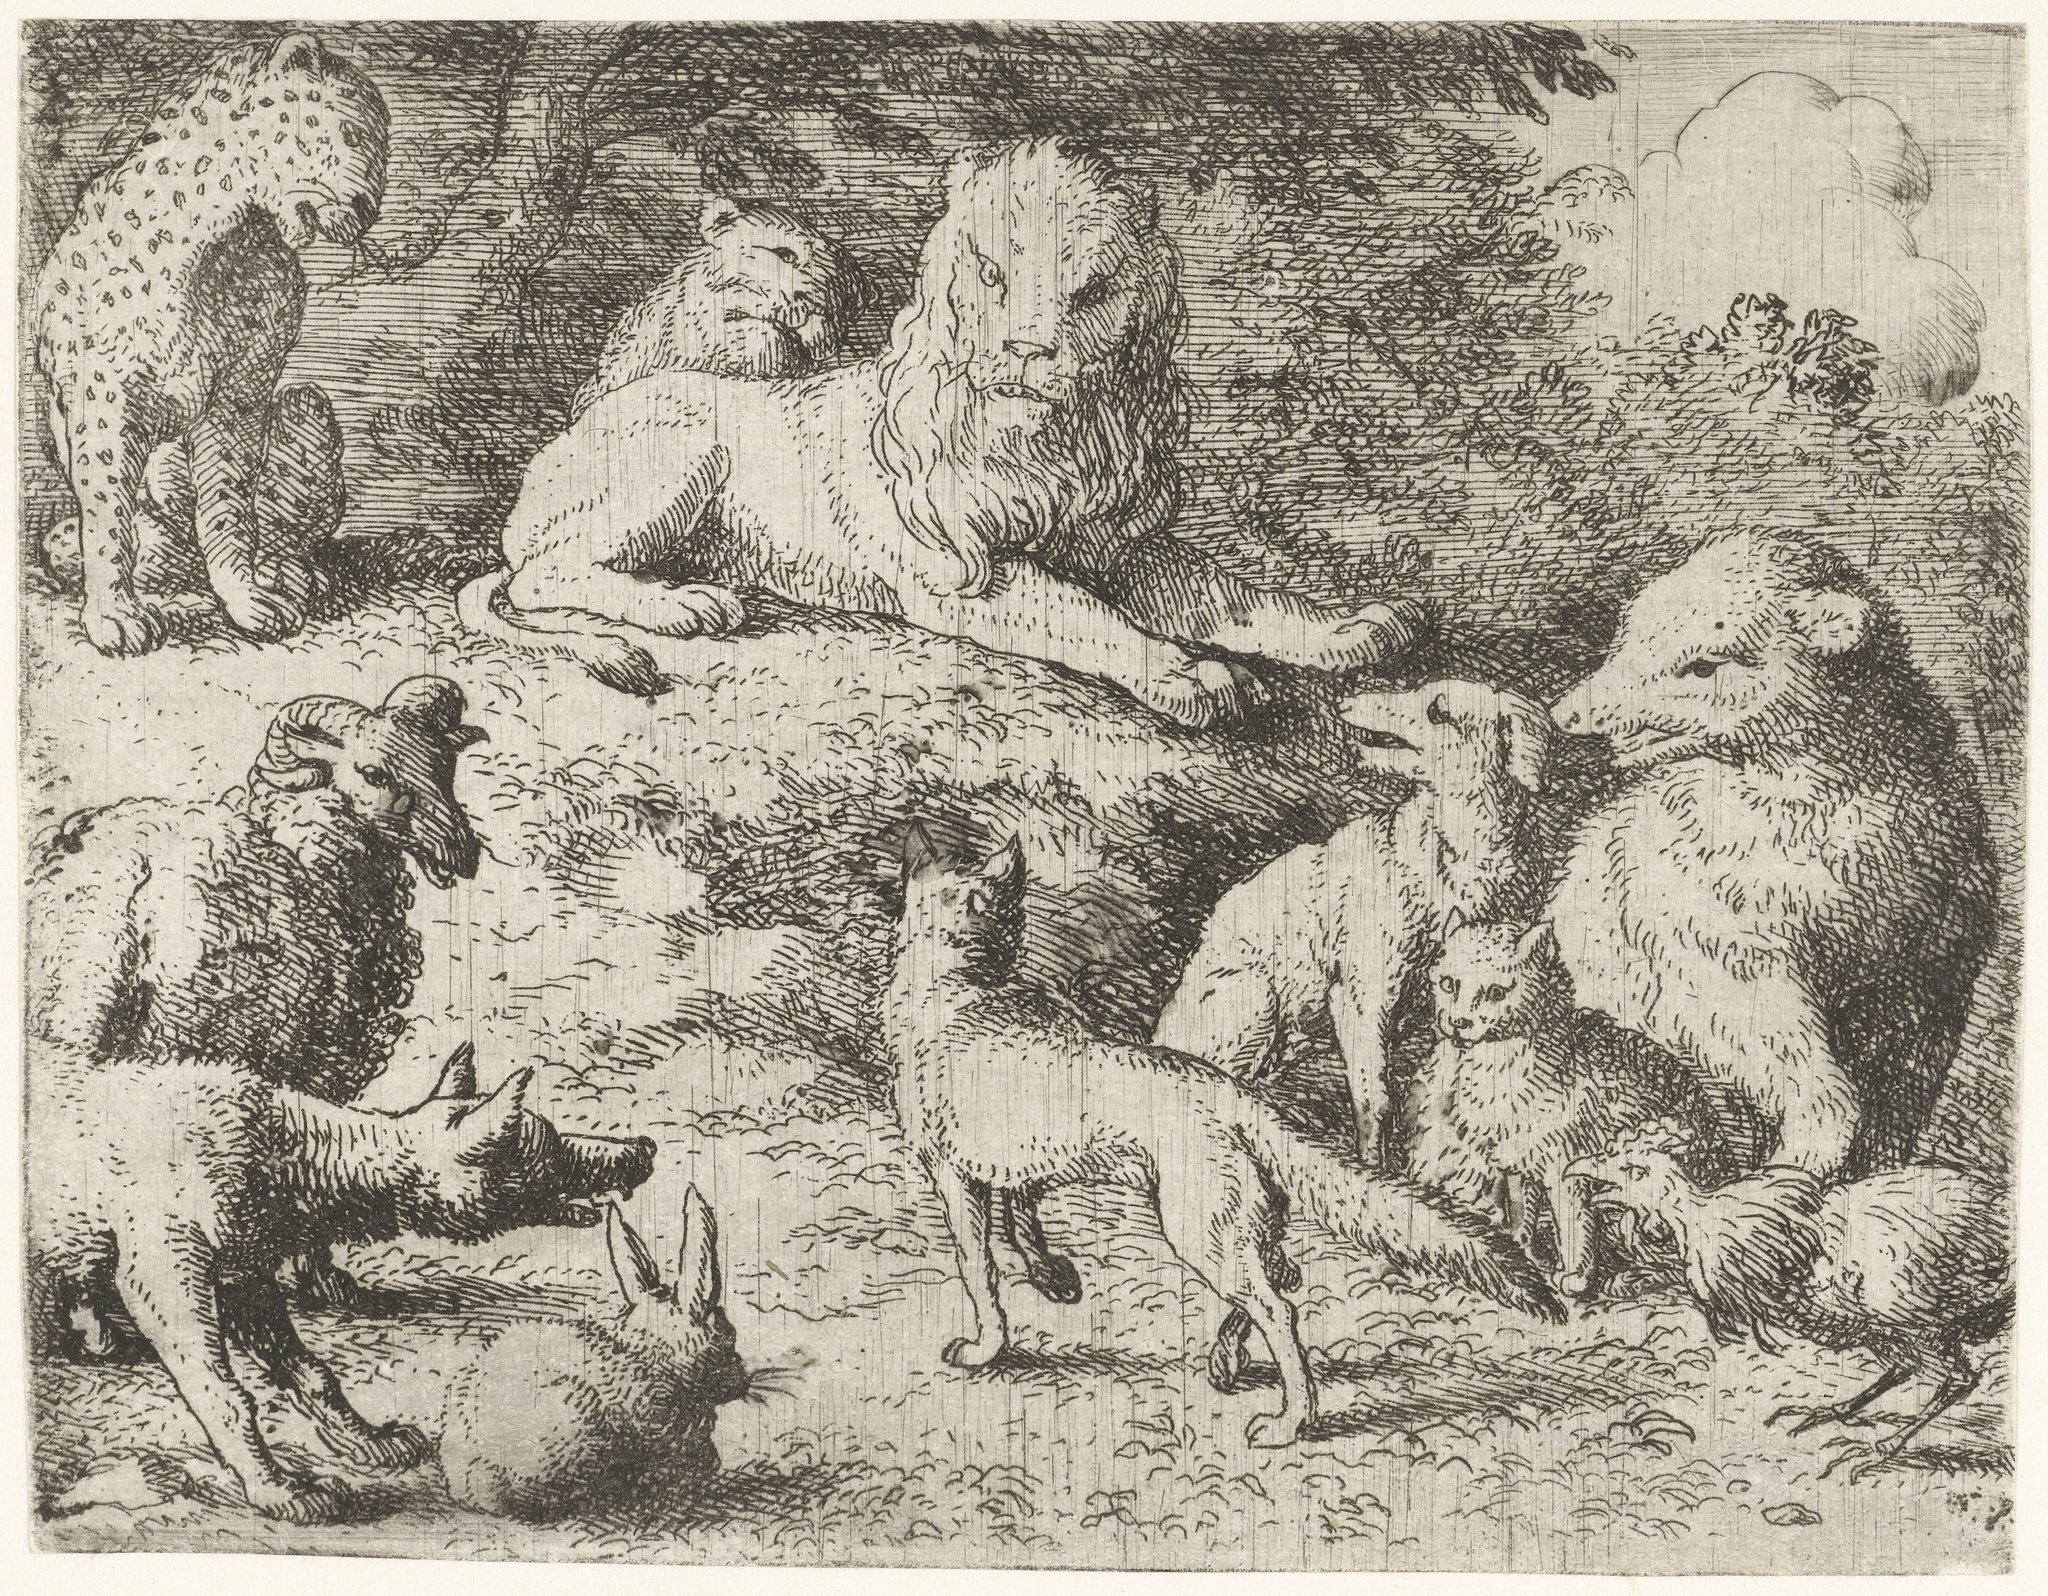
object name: print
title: Reinaert de vos verschijnt voor het gerecht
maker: allaert van everdingen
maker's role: draughtsman, painter, print maker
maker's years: 1621-1675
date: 1665-1675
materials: paper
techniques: etching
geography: netherlands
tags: fable of reynard the fox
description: Reinaert de vos, op de rug gezien, omringd door Belijn de ram, Isengrijn de wolf en Cuwaert de haas en aan de andere kant Bruun de beer, Tibert de kat en Canteclaer de haan. Op de heuvel ligt koning Nobel, de leeuw.